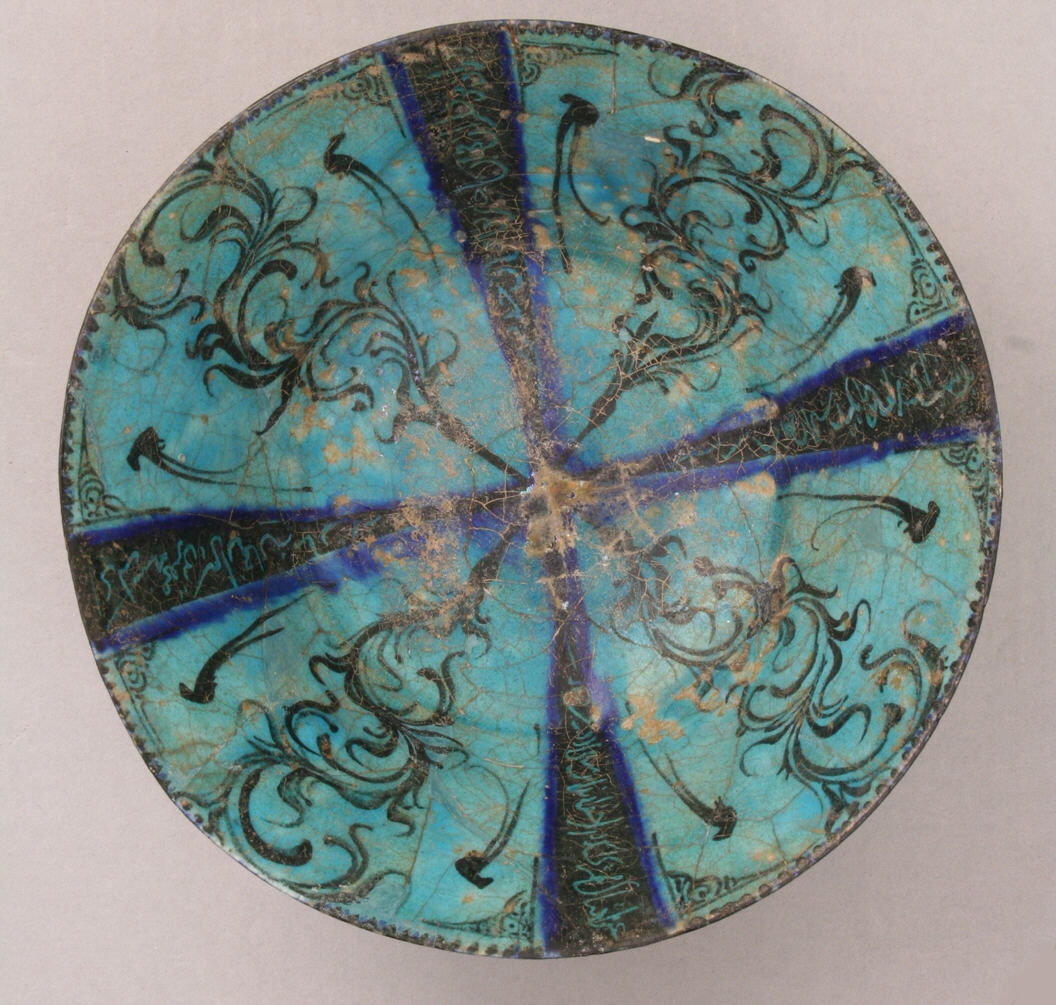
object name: bowl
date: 1201-1300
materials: earthenware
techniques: painting, underglaze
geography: iran